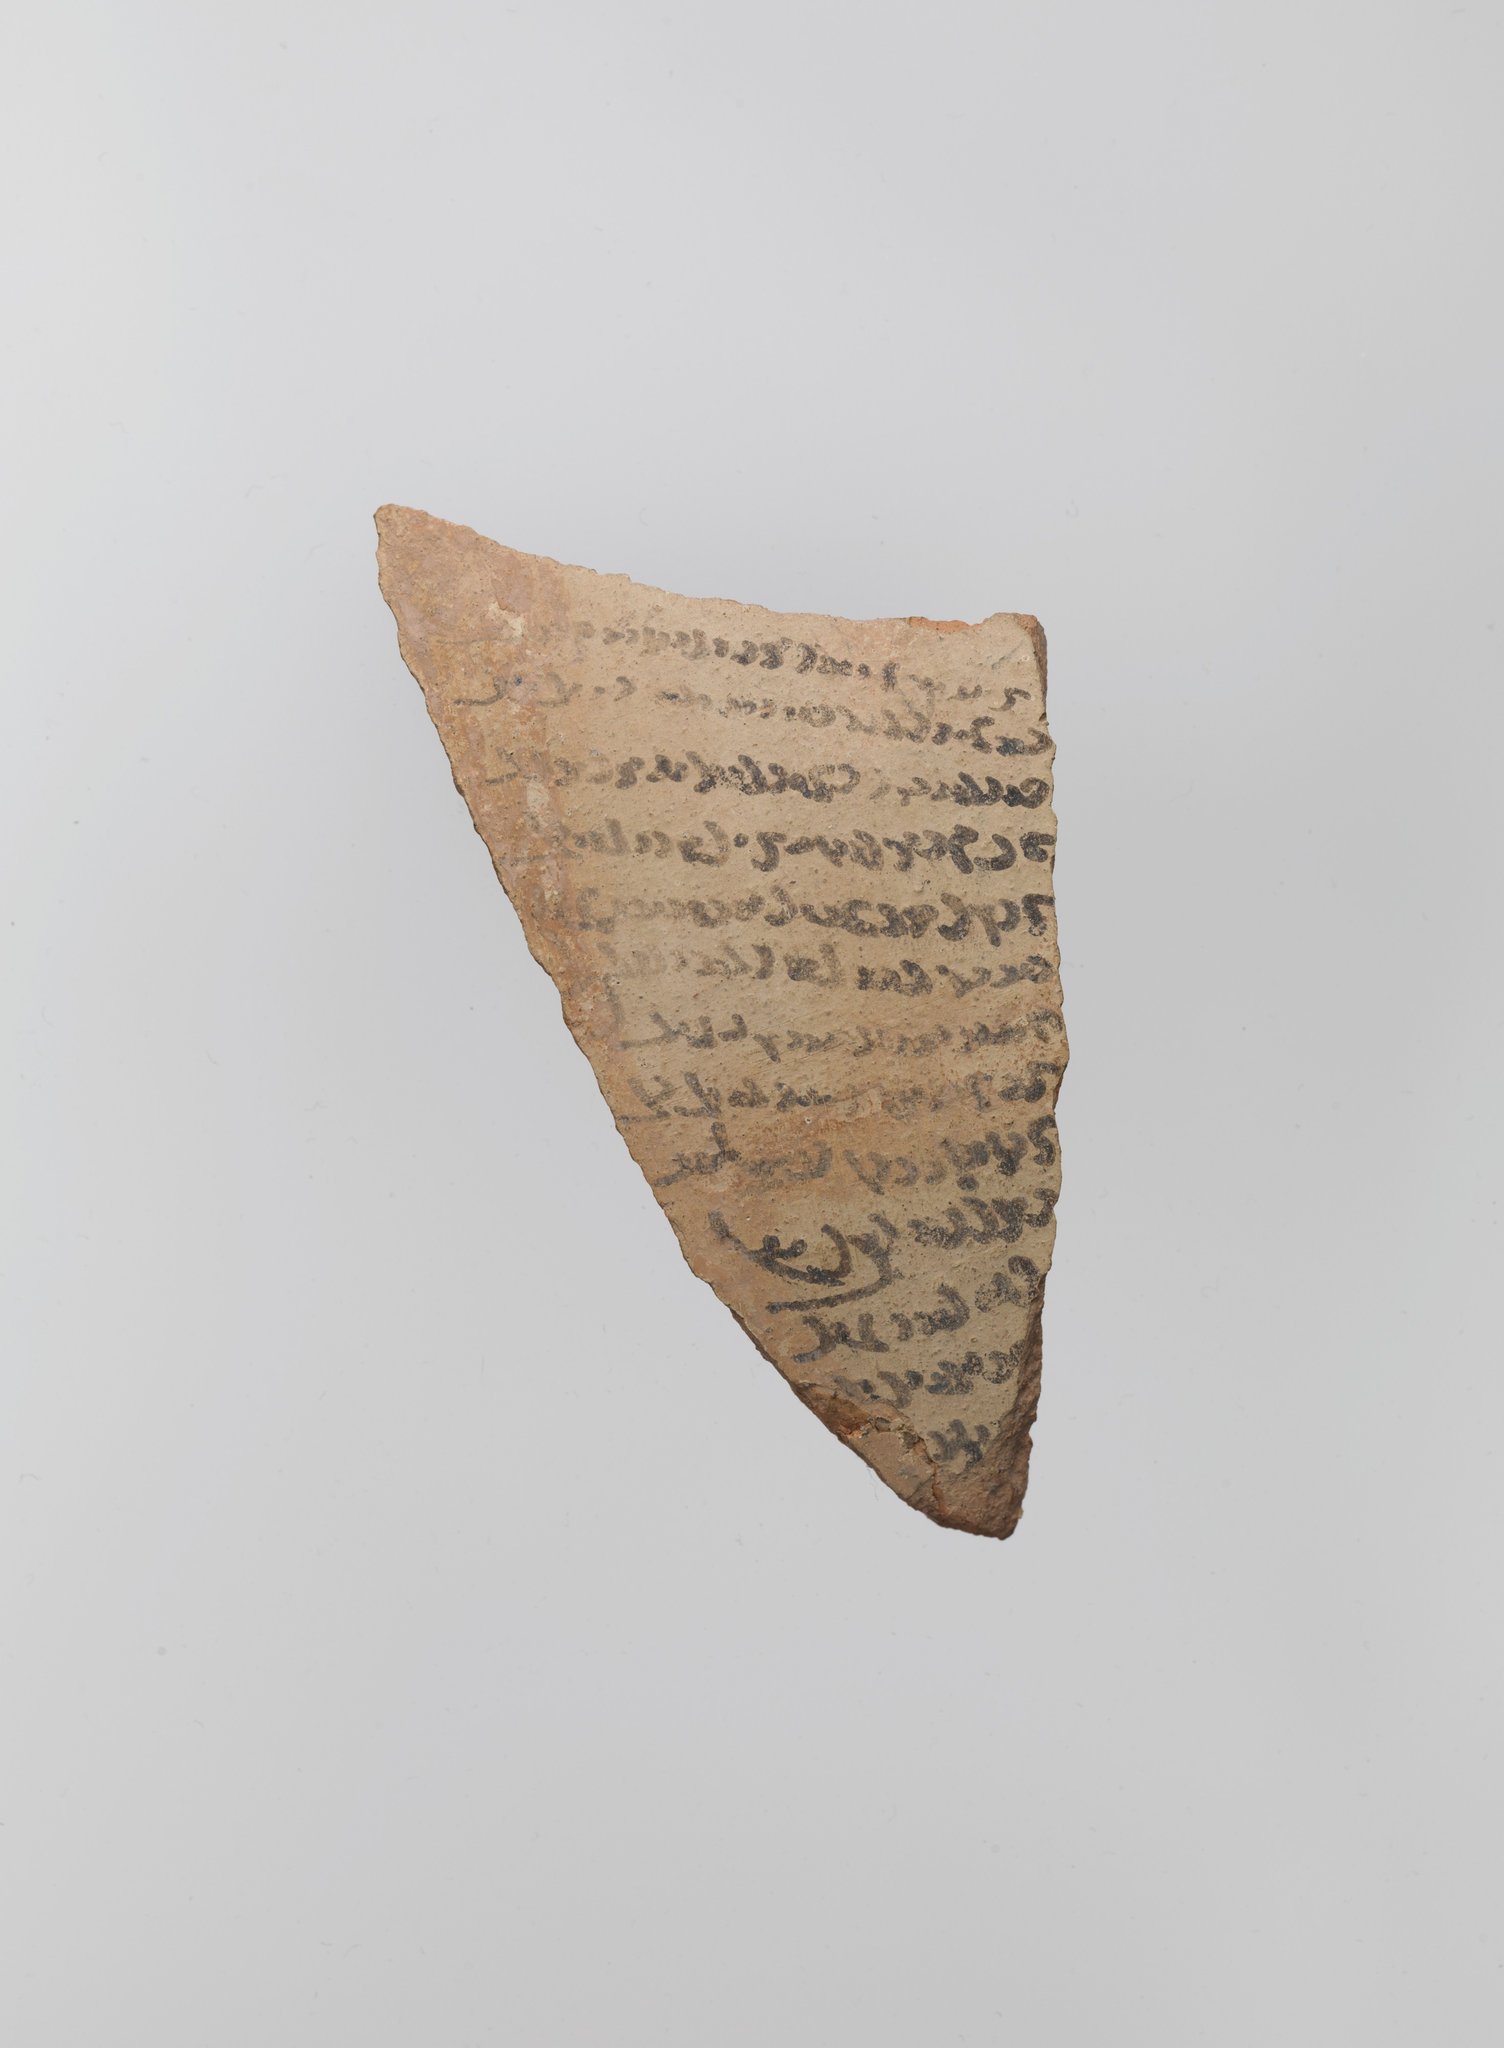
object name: fragment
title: Magic Bowl and an Ostrakon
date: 801-1000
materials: earthenware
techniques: painting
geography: iran